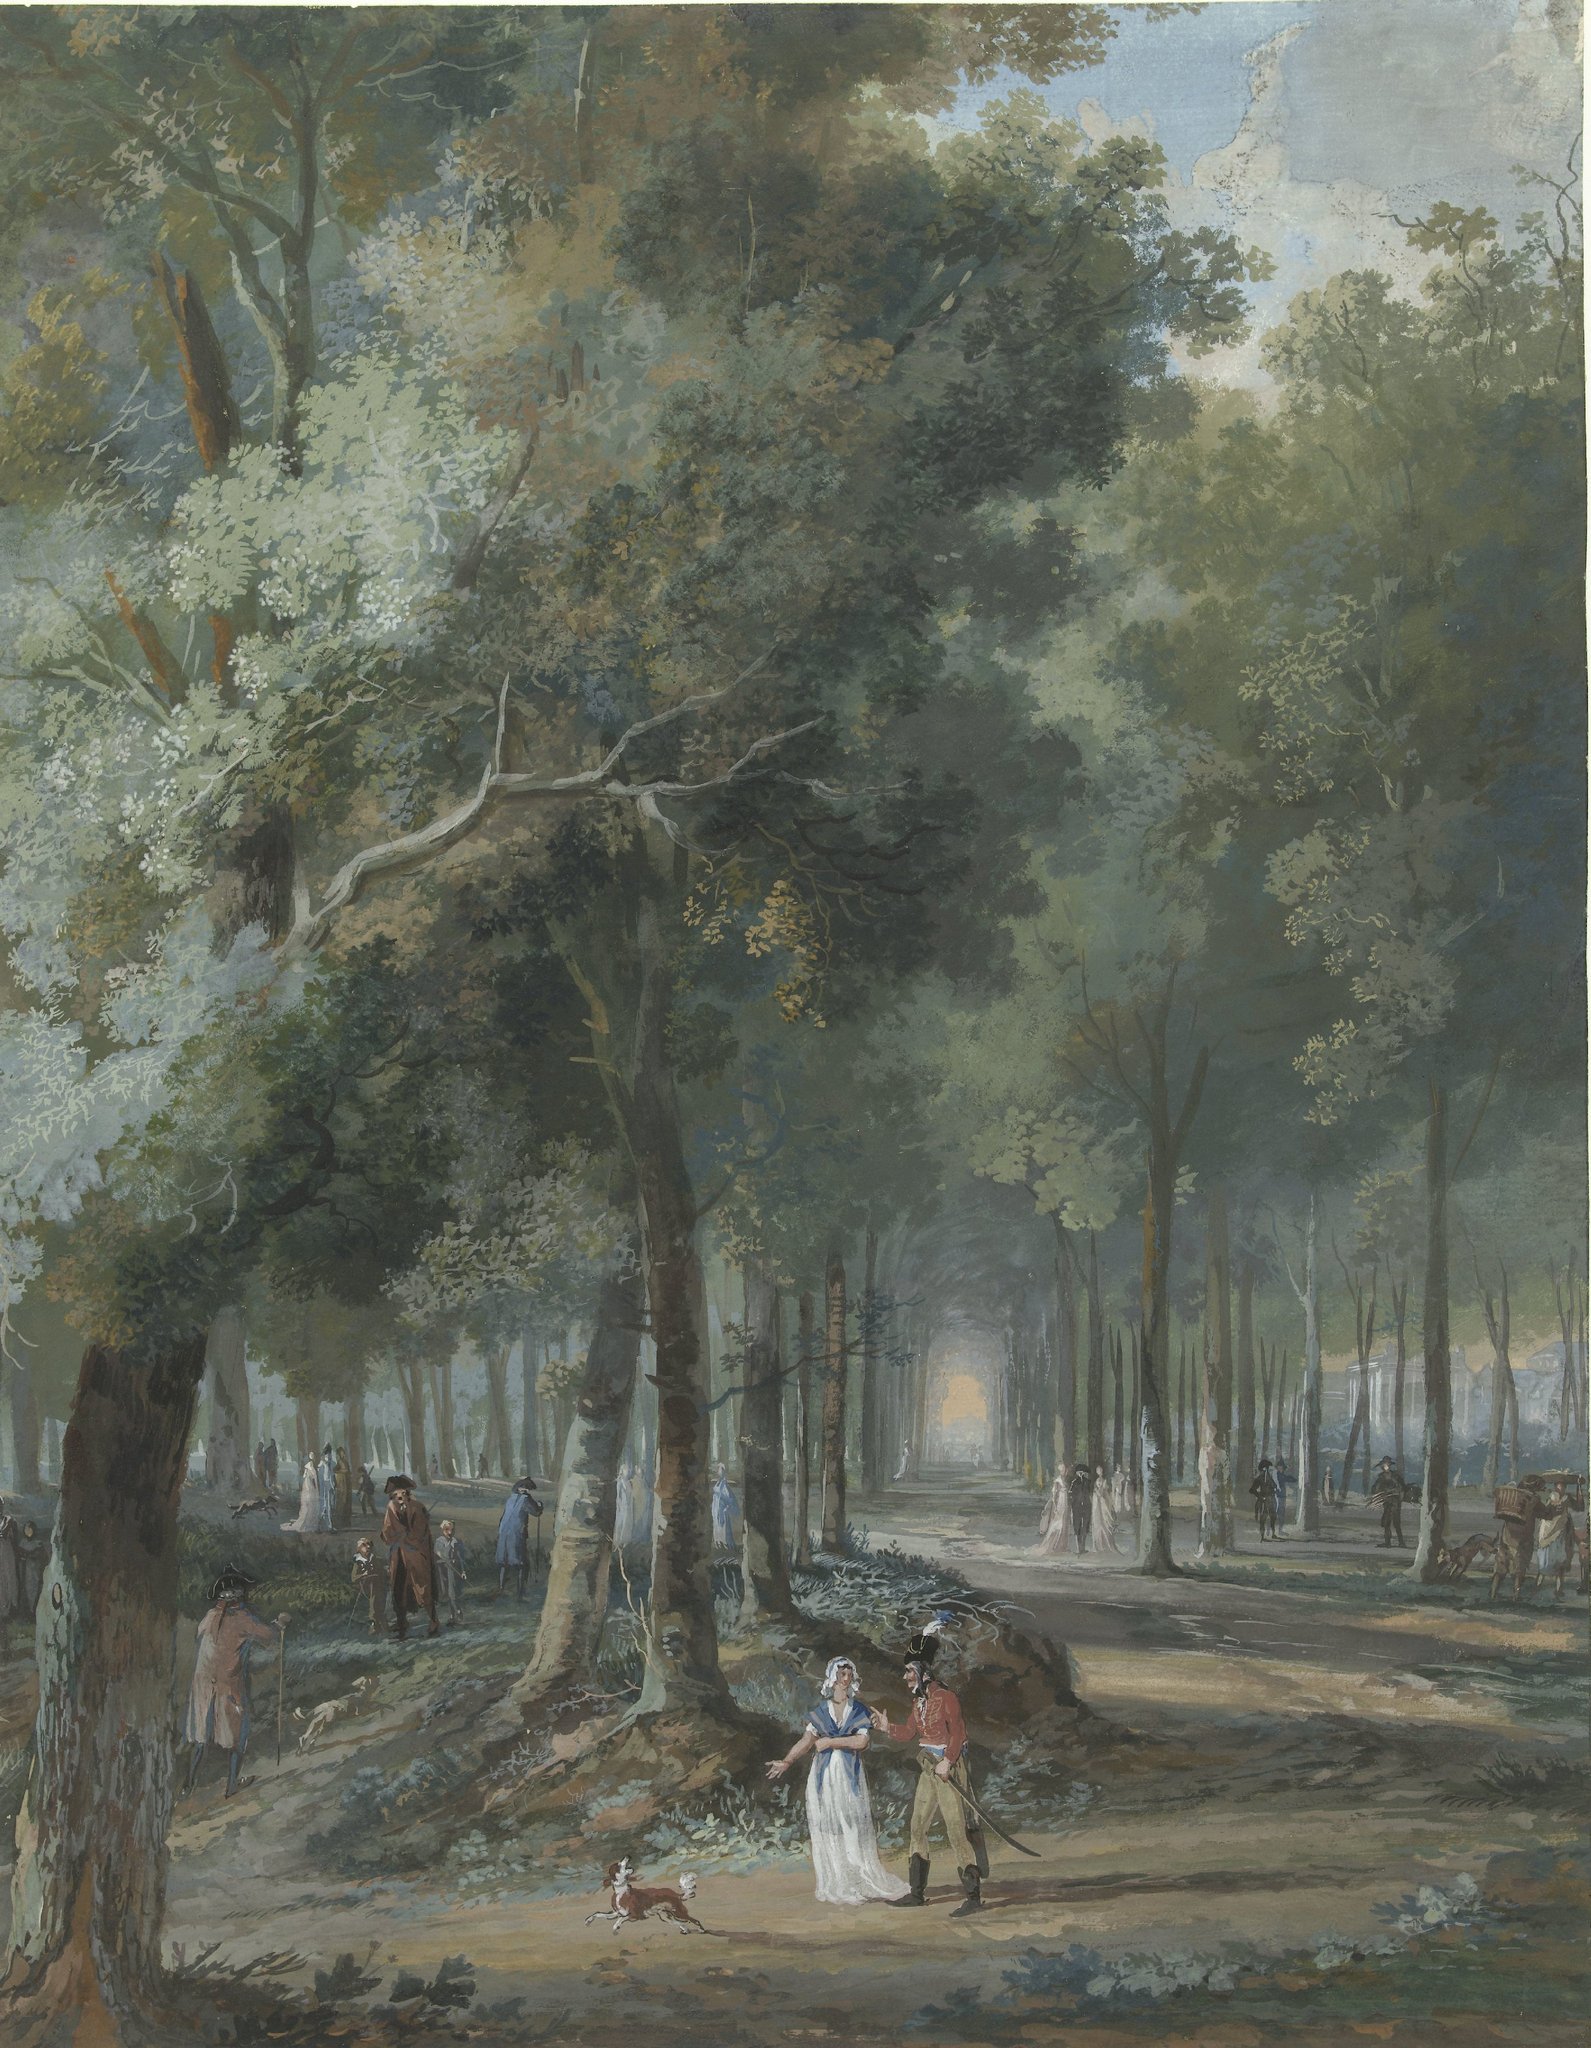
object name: drawing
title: Wandelaars in een park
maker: arie lamme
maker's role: draughtsman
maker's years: 1748-1801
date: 1758-1801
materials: paint, paper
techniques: brush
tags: park